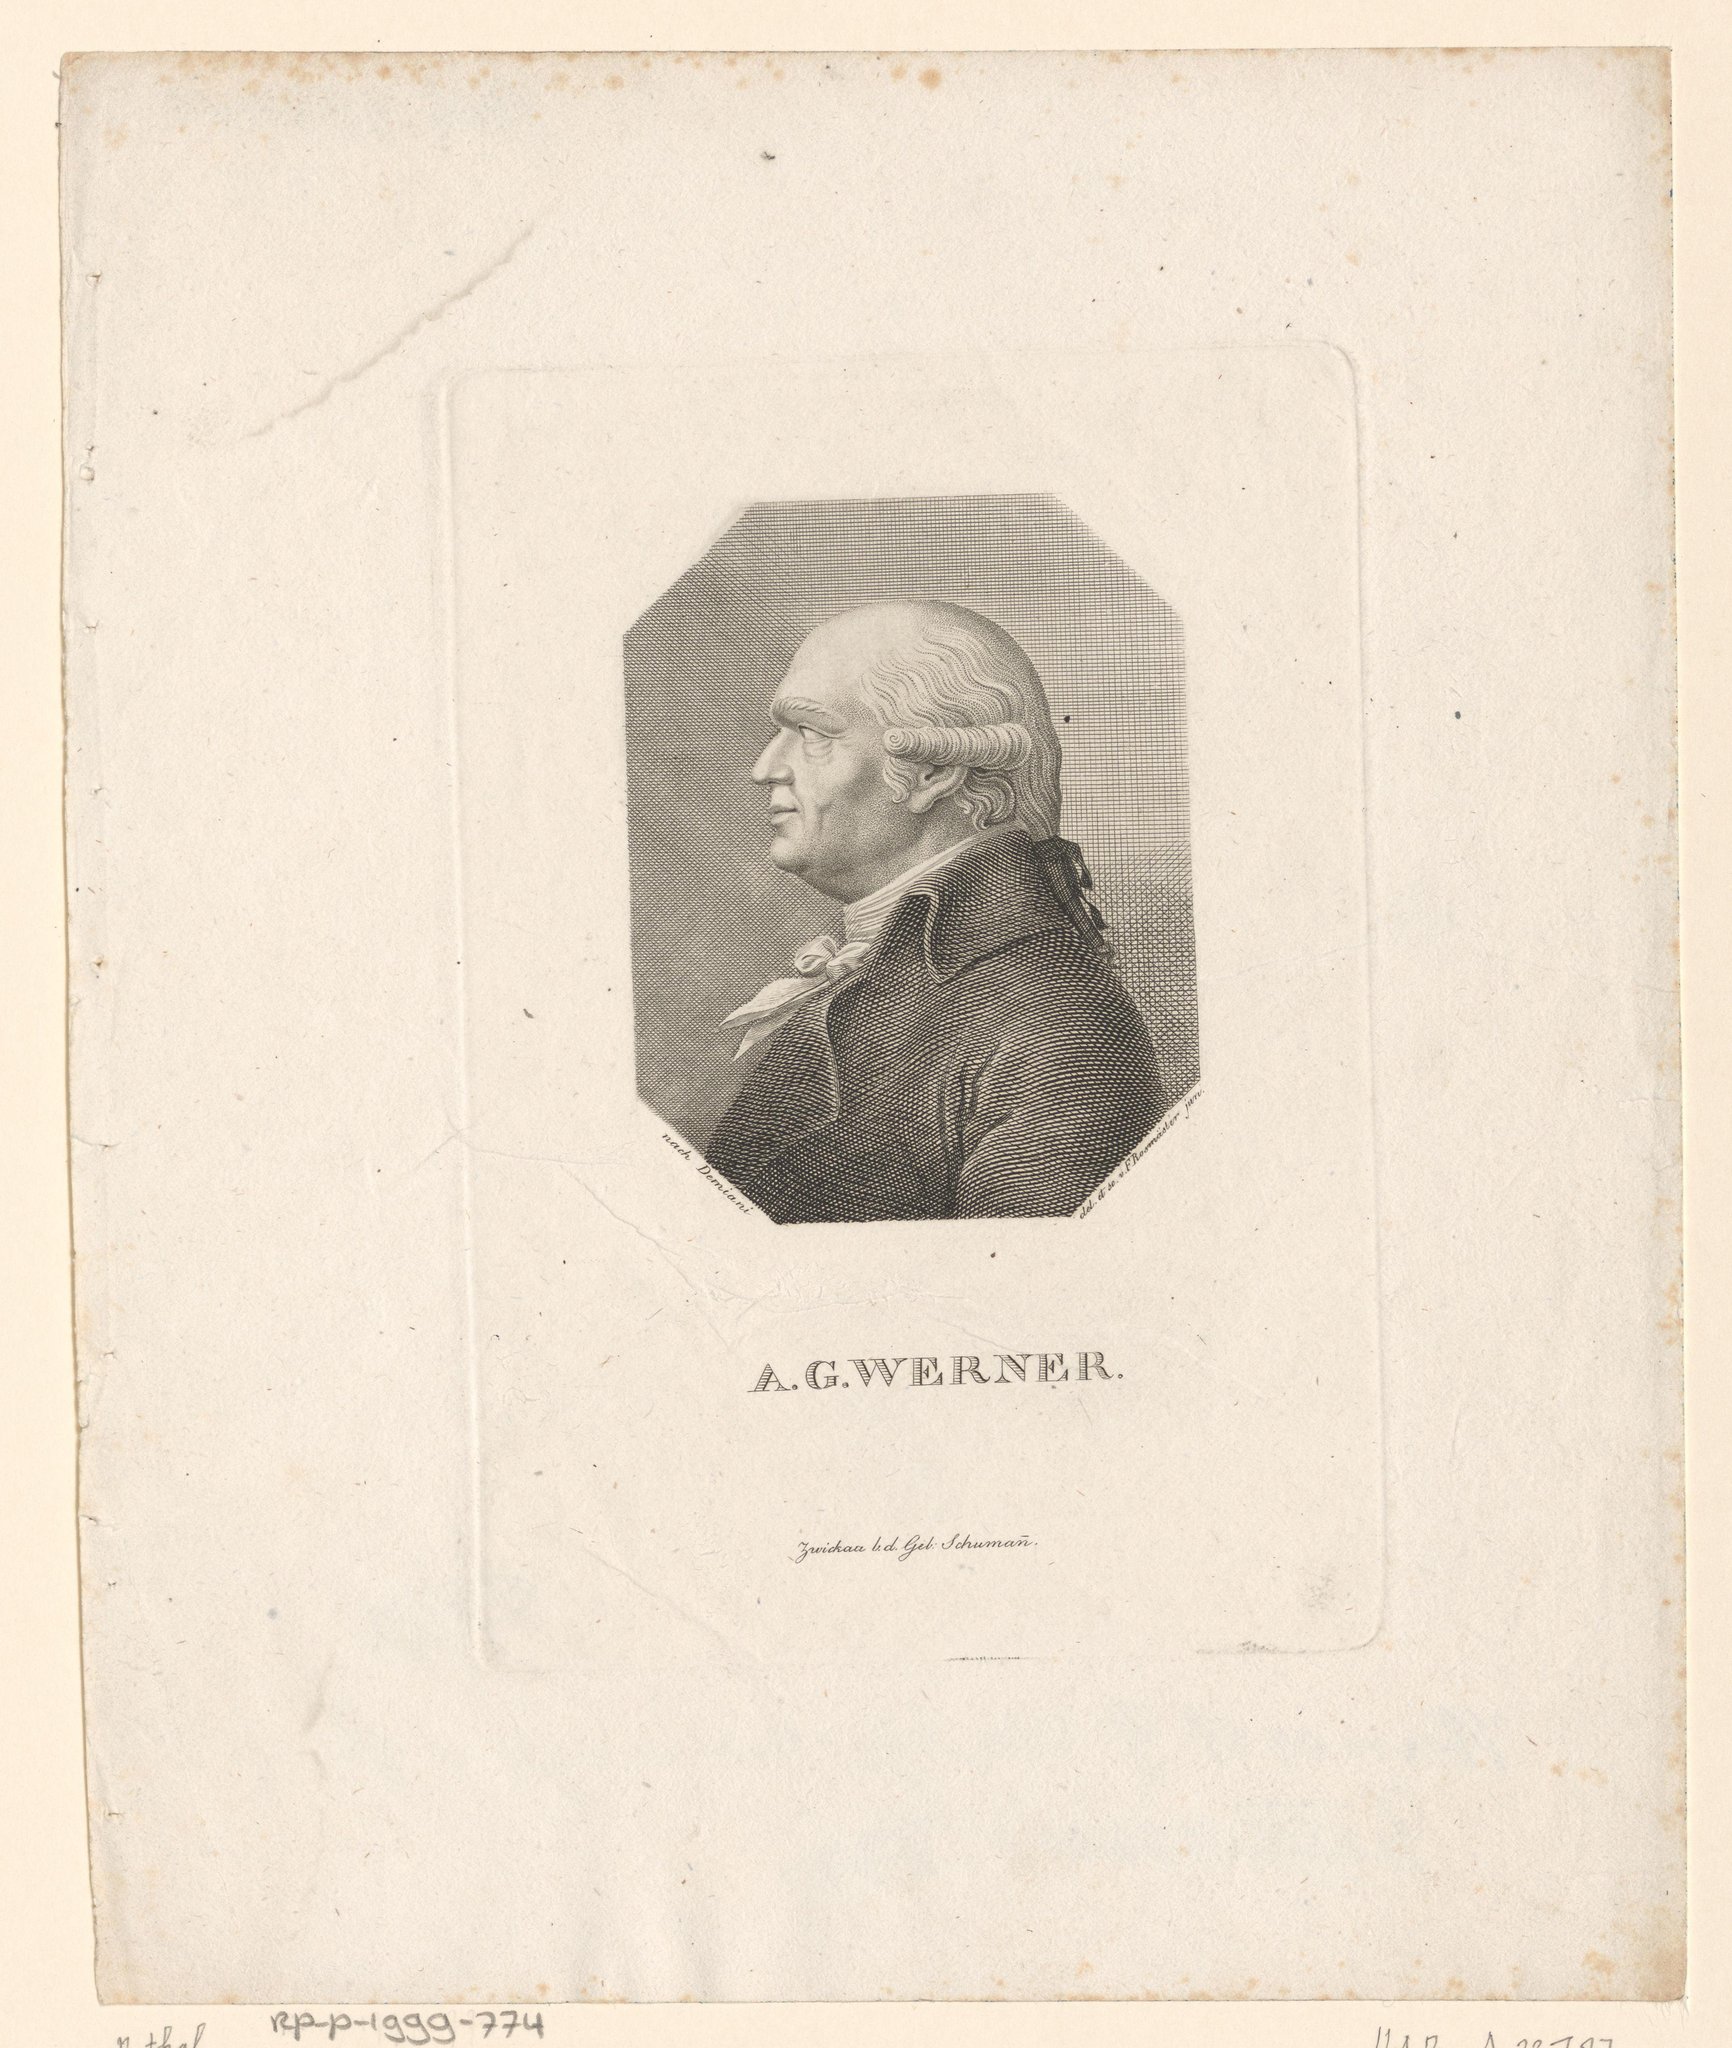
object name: print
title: Portret Abraham Gottlob Werner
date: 1804-1843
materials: paper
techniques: engraving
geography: zwickau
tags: historical persons, professor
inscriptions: collector's mark: Lugt 2228